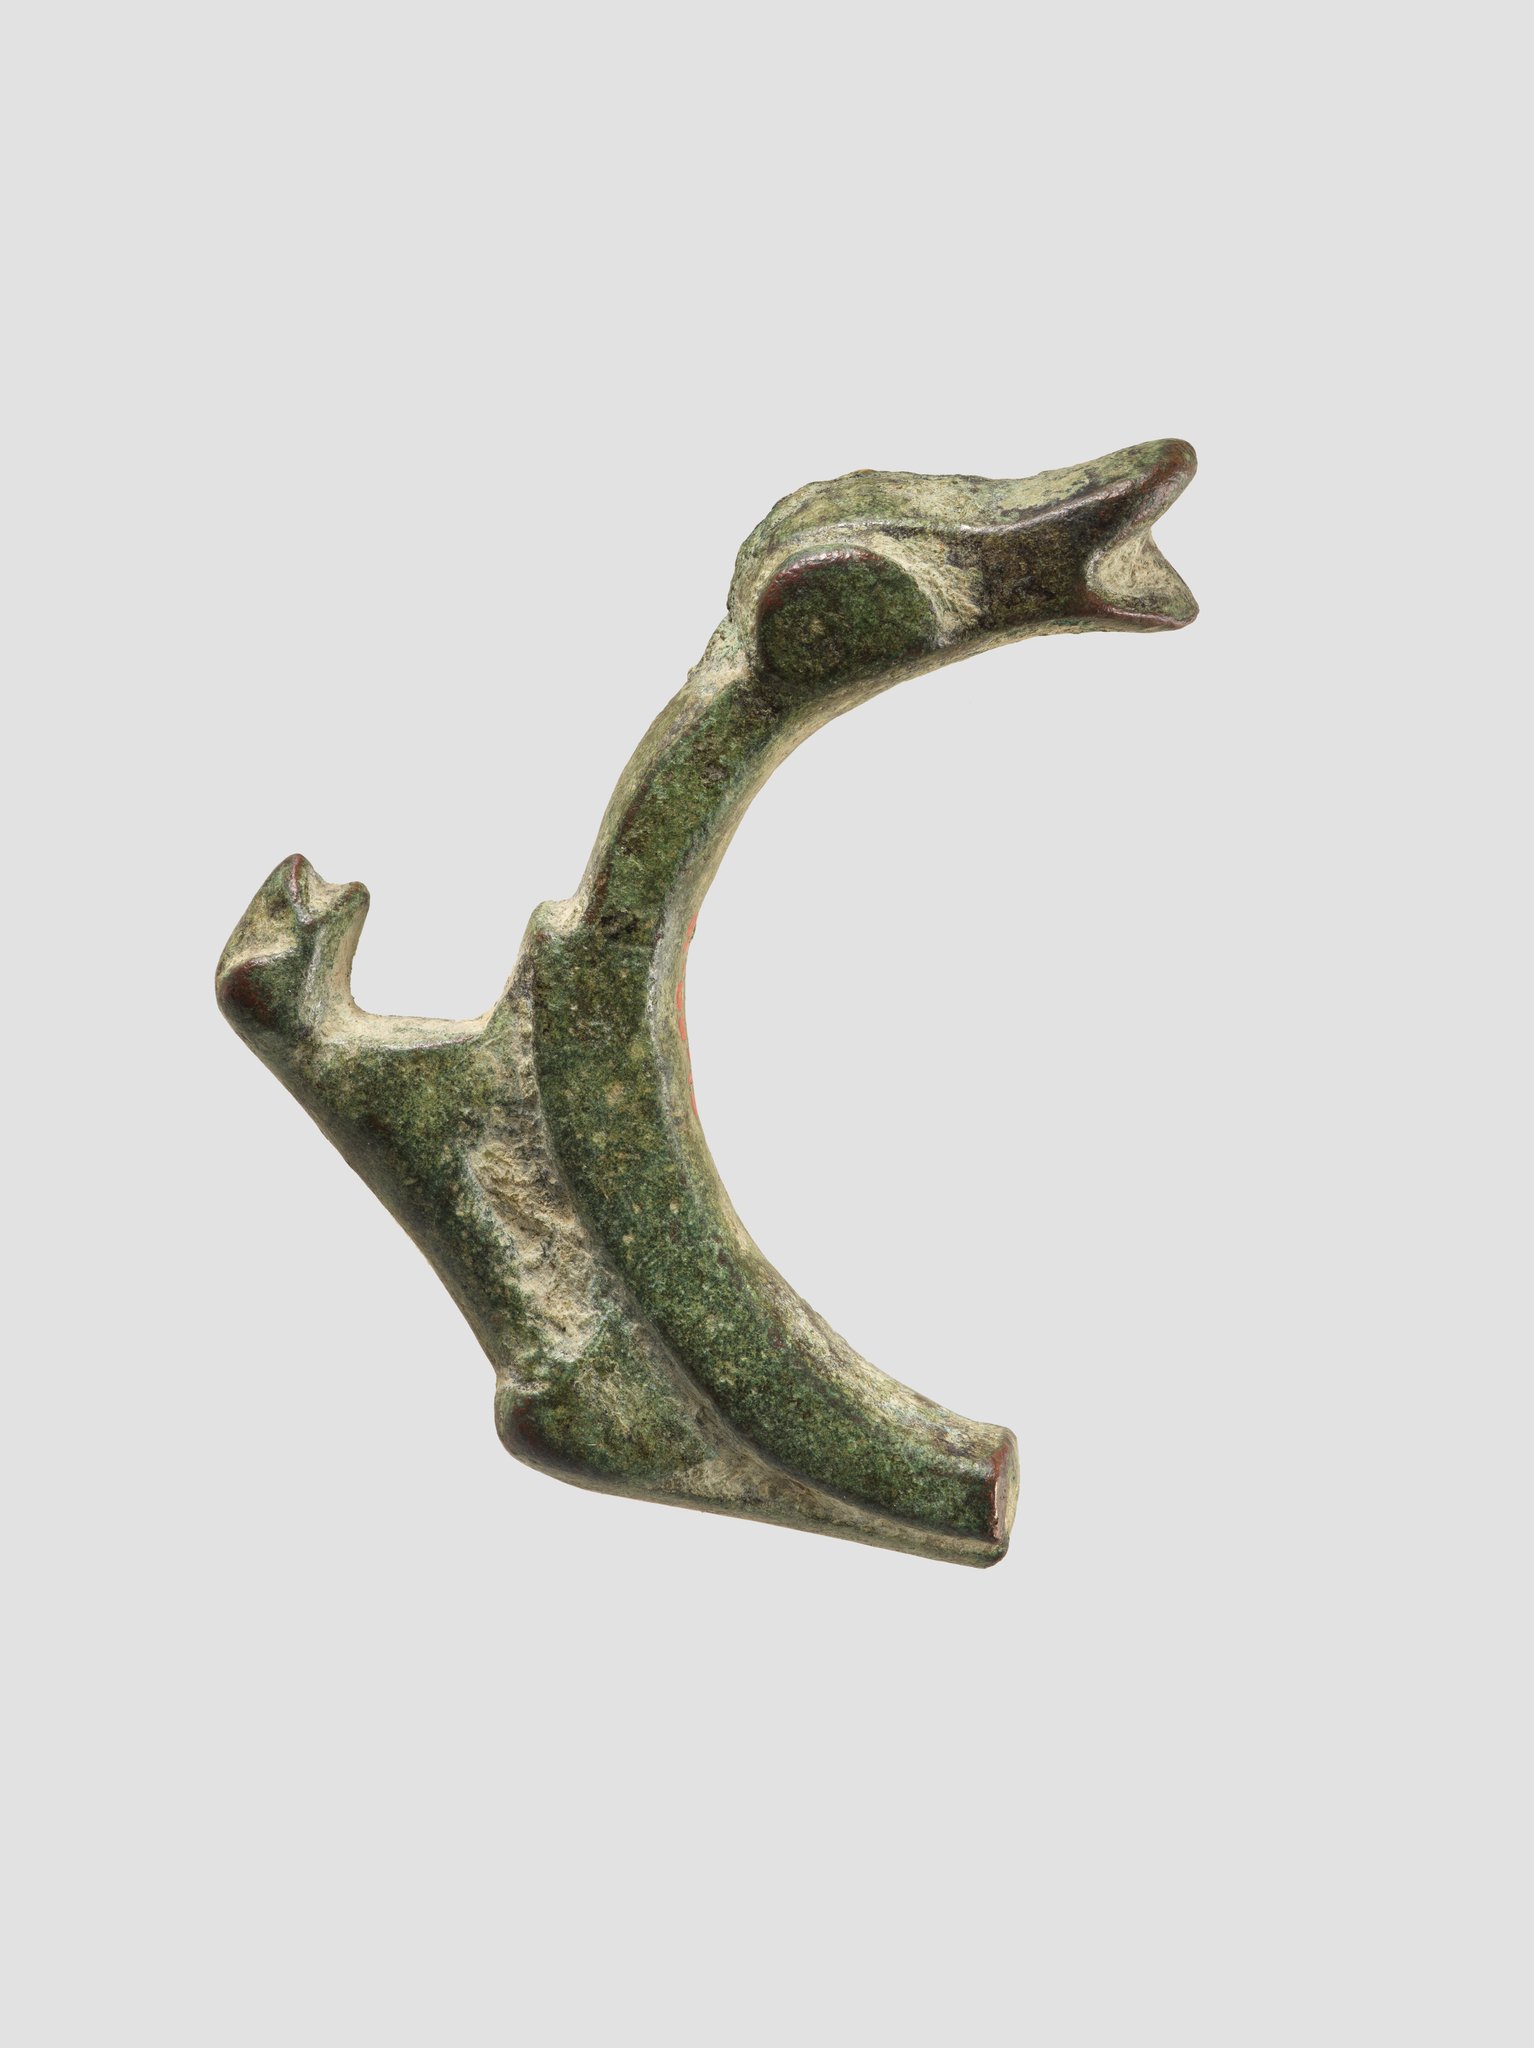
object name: bracelet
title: Bracelet fragment (?)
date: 1-1000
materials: bronze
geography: anatolia (?)